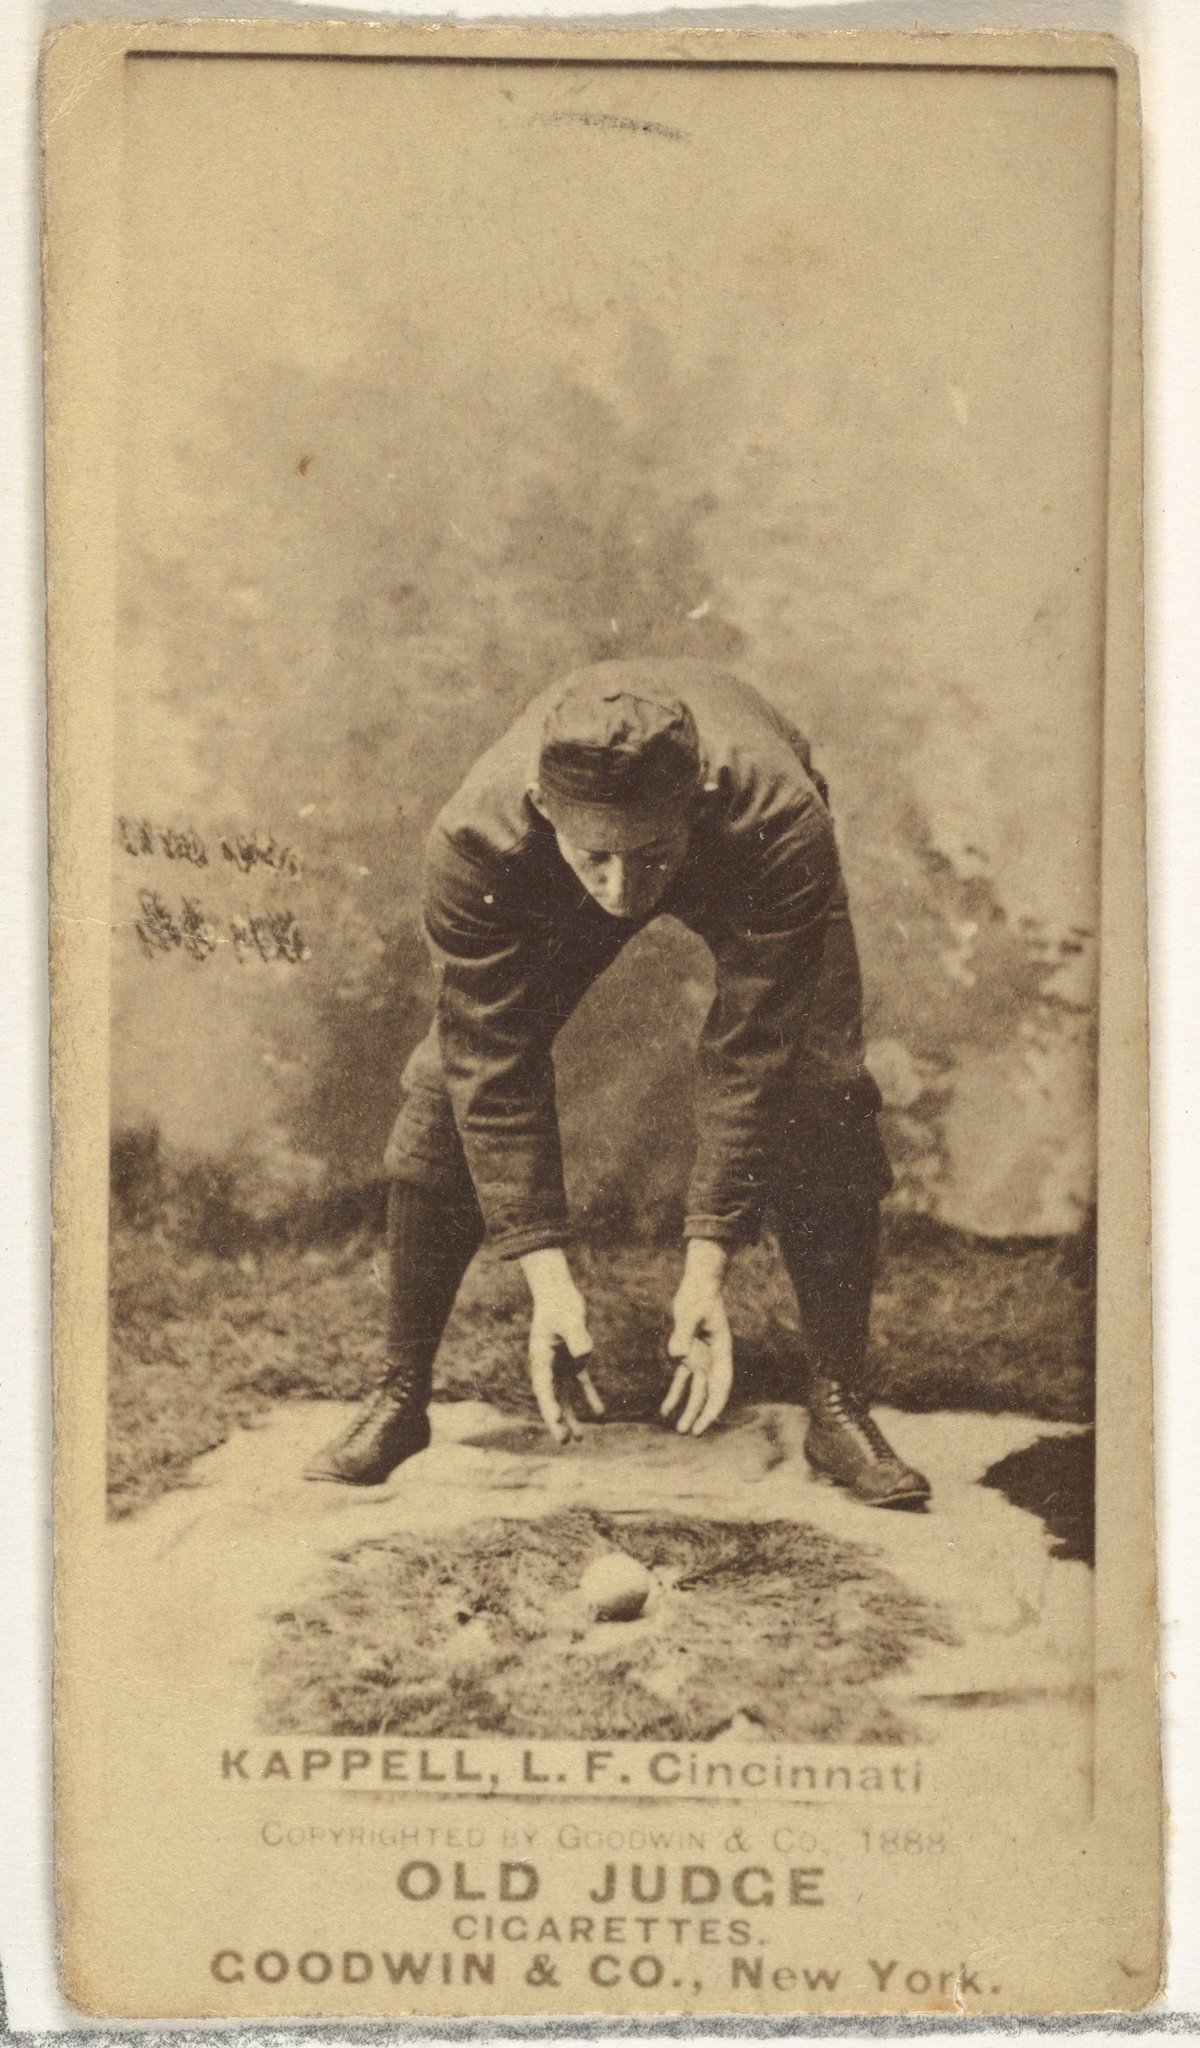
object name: baseball card, photograph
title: Henry "Heinie" Kappel, Left Field, Cincinnati, from the Old Judge series (N172) for Old Judge Cigarettes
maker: goodwin & company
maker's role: publisher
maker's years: 1850-1950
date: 1888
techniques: albumen silver print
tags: men,portraits,baseball,athletes